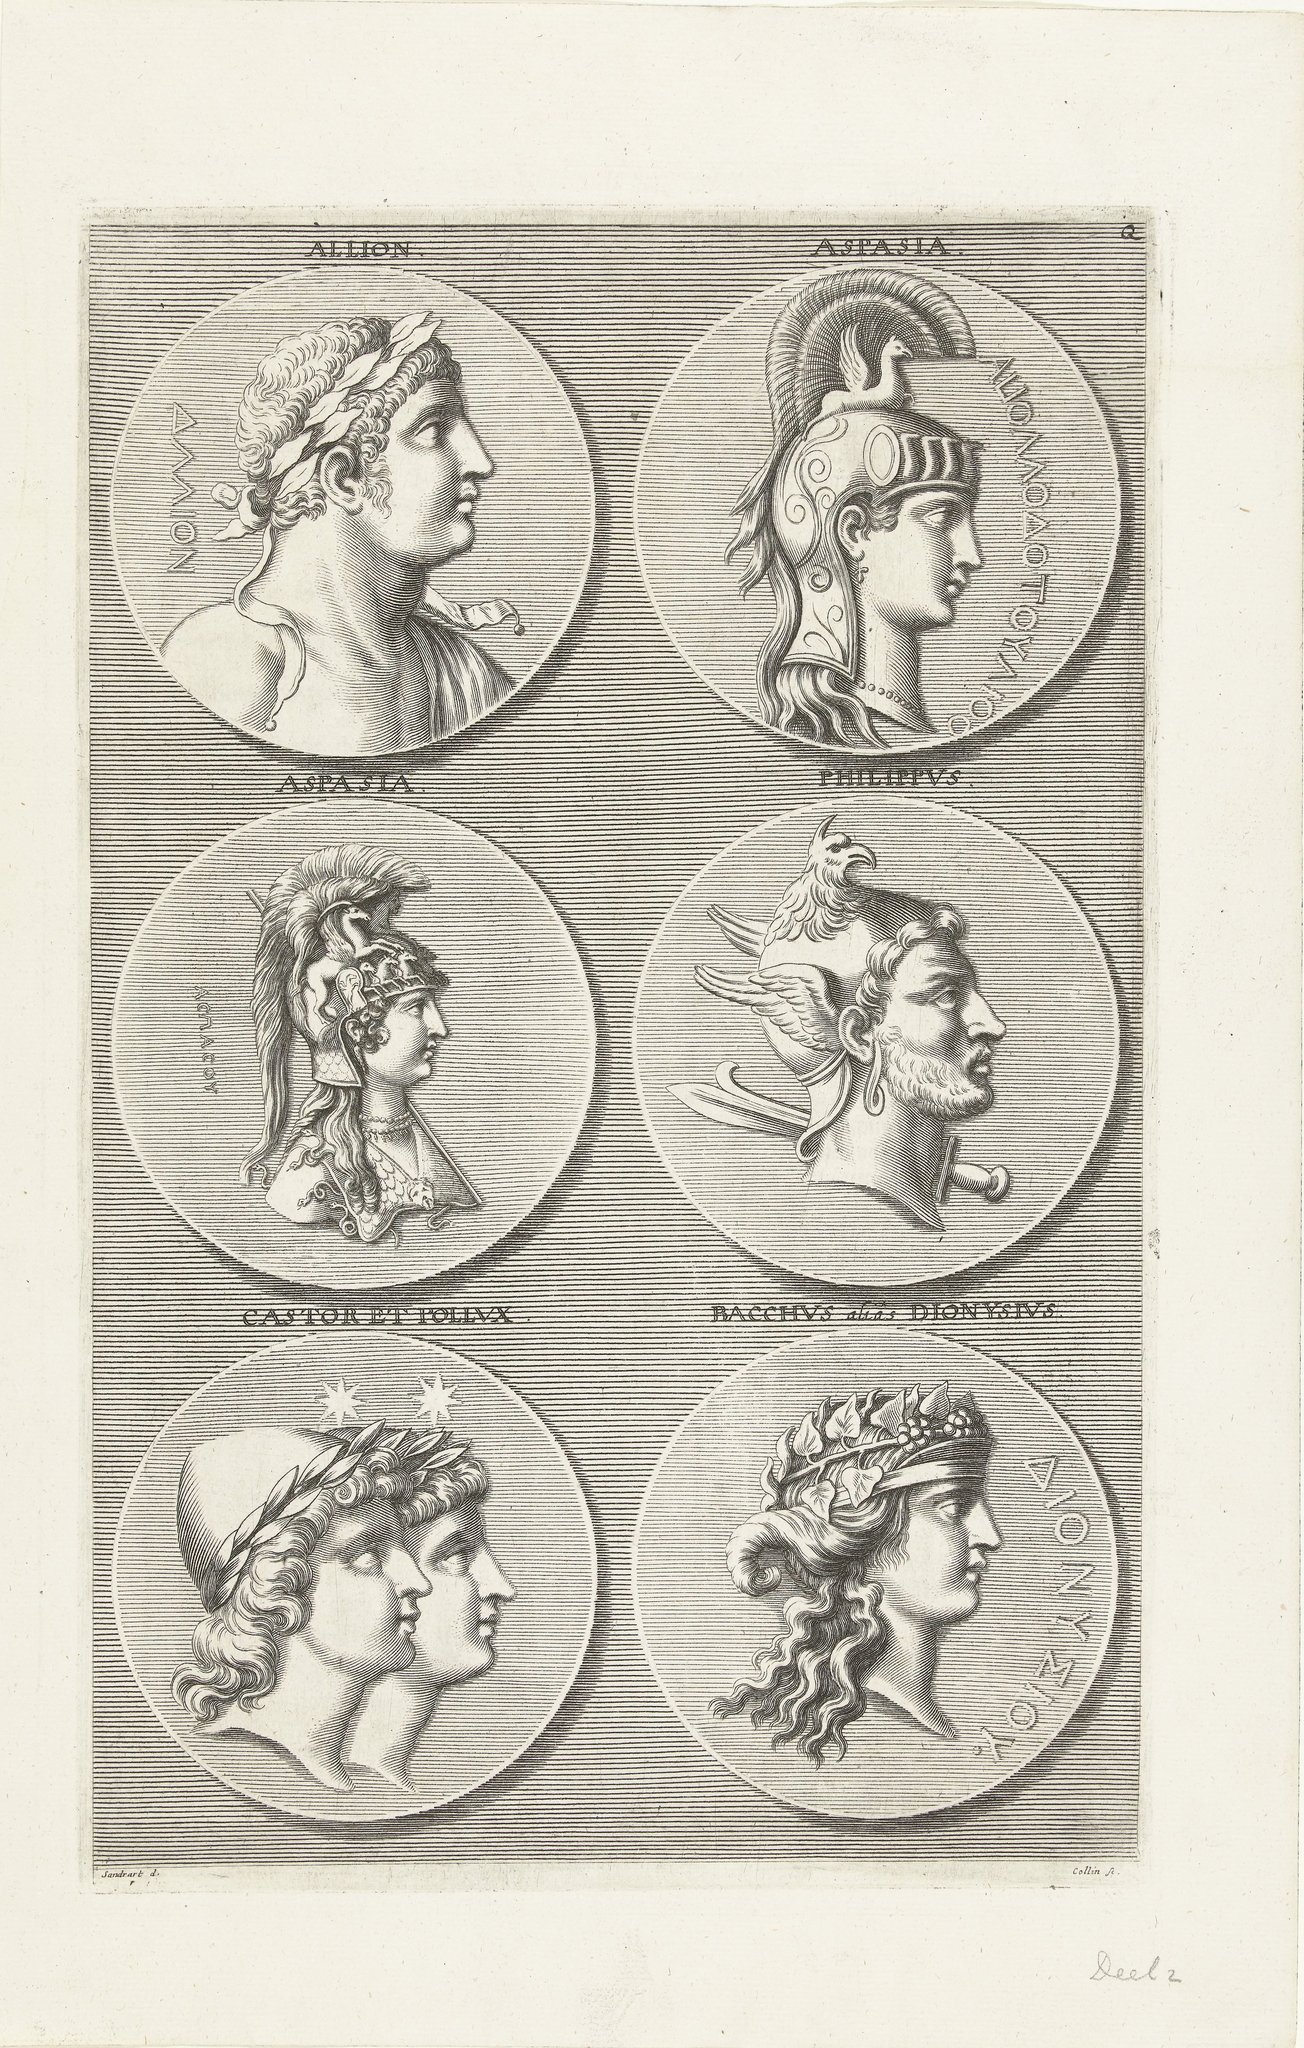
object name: print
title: Zes munten met portretten van mannen en vrouwen uit de klassieke oudheid en de mythologie: letter Q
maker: richard collin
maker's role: print maker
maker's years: 1627-1697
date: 1675-1680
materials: paper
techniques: engraving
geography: antwerp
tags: coin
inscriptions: collector's mark: Lugt 2228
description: Illustratie voor: Joachim von Sandrart, L'Academia Todesca della Architectura Scultura e Pittura oder Teutsche Academie der Edlen Bau-, Bild- und Mahlerey-Künste. Nürnberg: 1675-1680.